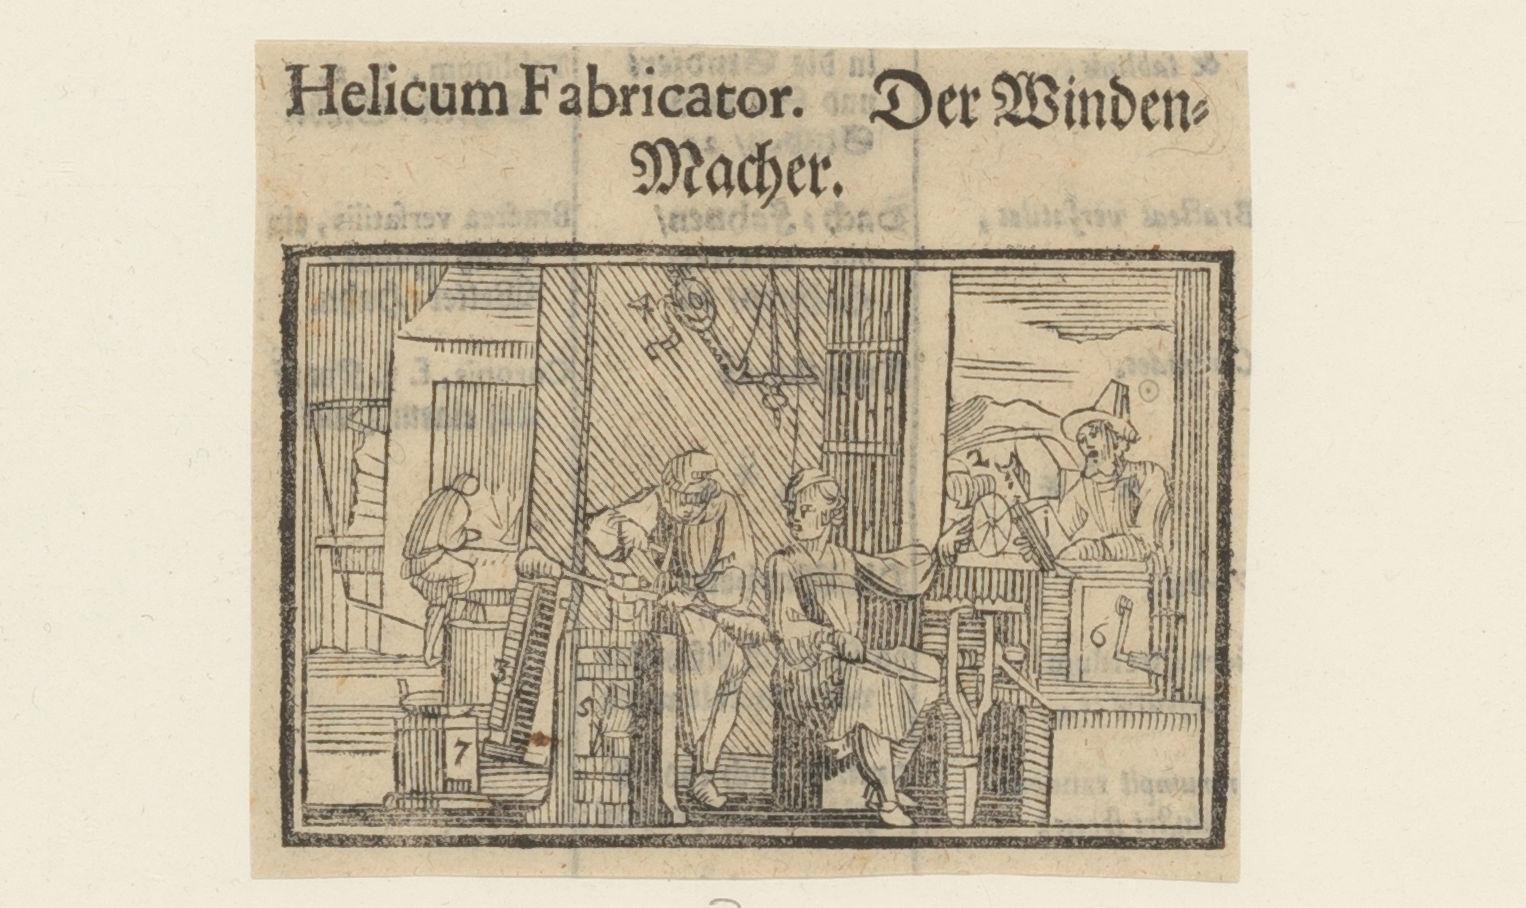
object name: print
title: Helicum Fabricatot. Der Winden-Macher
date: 1719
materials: paper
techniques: letterpress printing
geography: nuremberg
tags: tools, aids, implements ~ crafts and industries: windlass, handicrafts, craftsman at work, parts of ship's interior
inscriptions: stamp, collector's mark: Lugt 1641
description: Prent uit: Comenius, Johannes Amosius. Orbis sensualium picti pars prima (...). Neurenberg: Martin Endter, 1719, dl. 2, p. 228. Prent eerder gebruikt in: Comenius, Johannes Amosius. Orbis Sensualium Picti denuo aucti Pars Secunda (...). Neurenberg: Martin Endter, 1730, dl. 2.